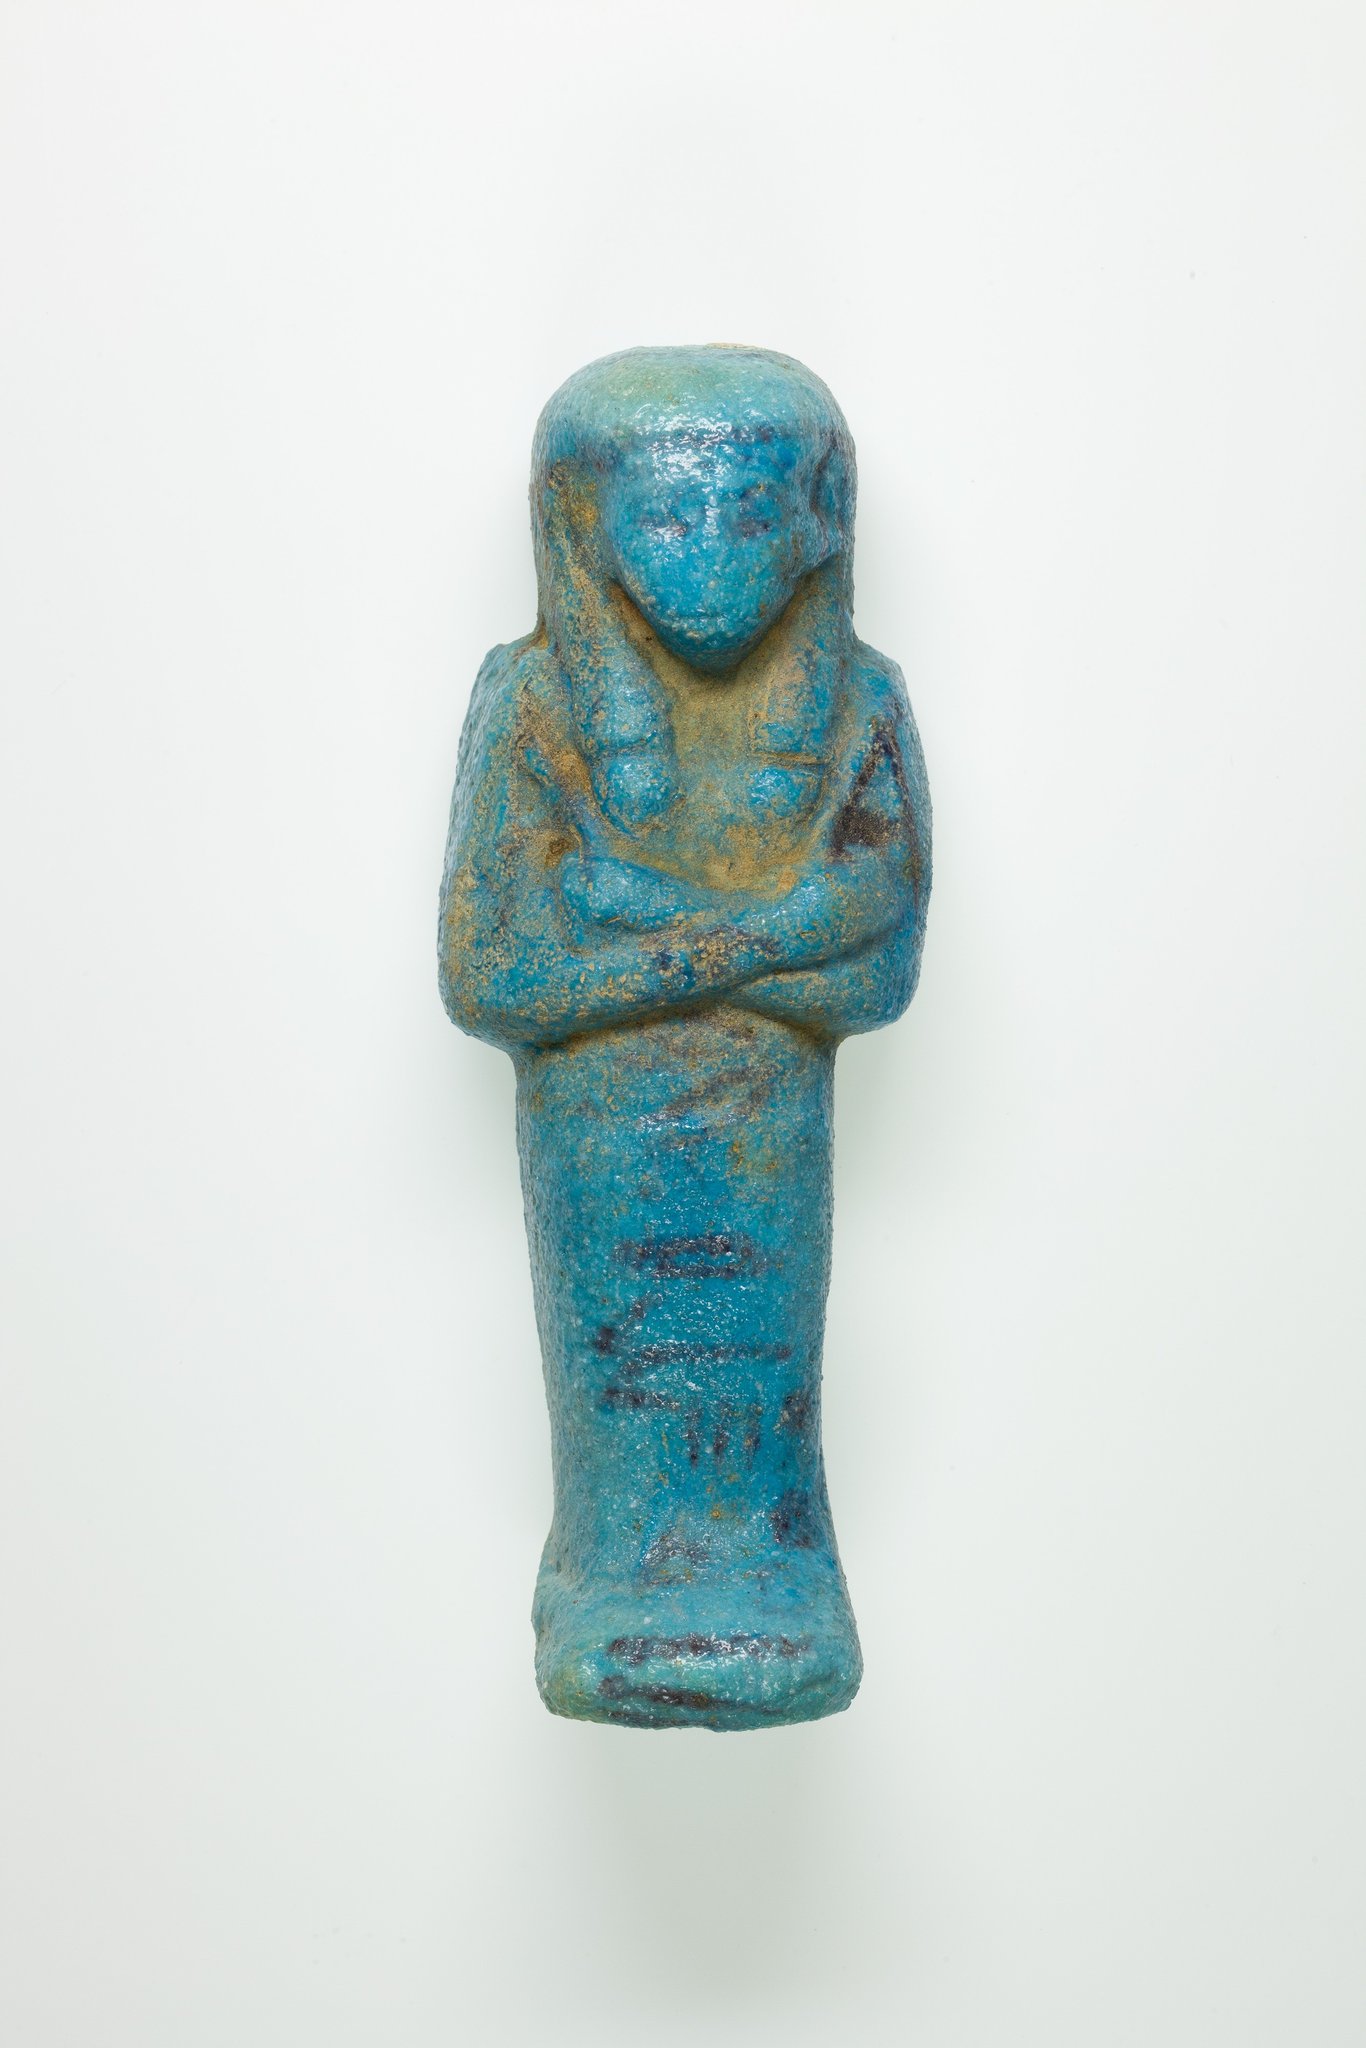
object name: worker shabti, henettawy c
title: Worker Shabti of Henettawy (C), Daughter of Isetemkheb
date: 990-970 BCE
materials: faience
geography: egypt